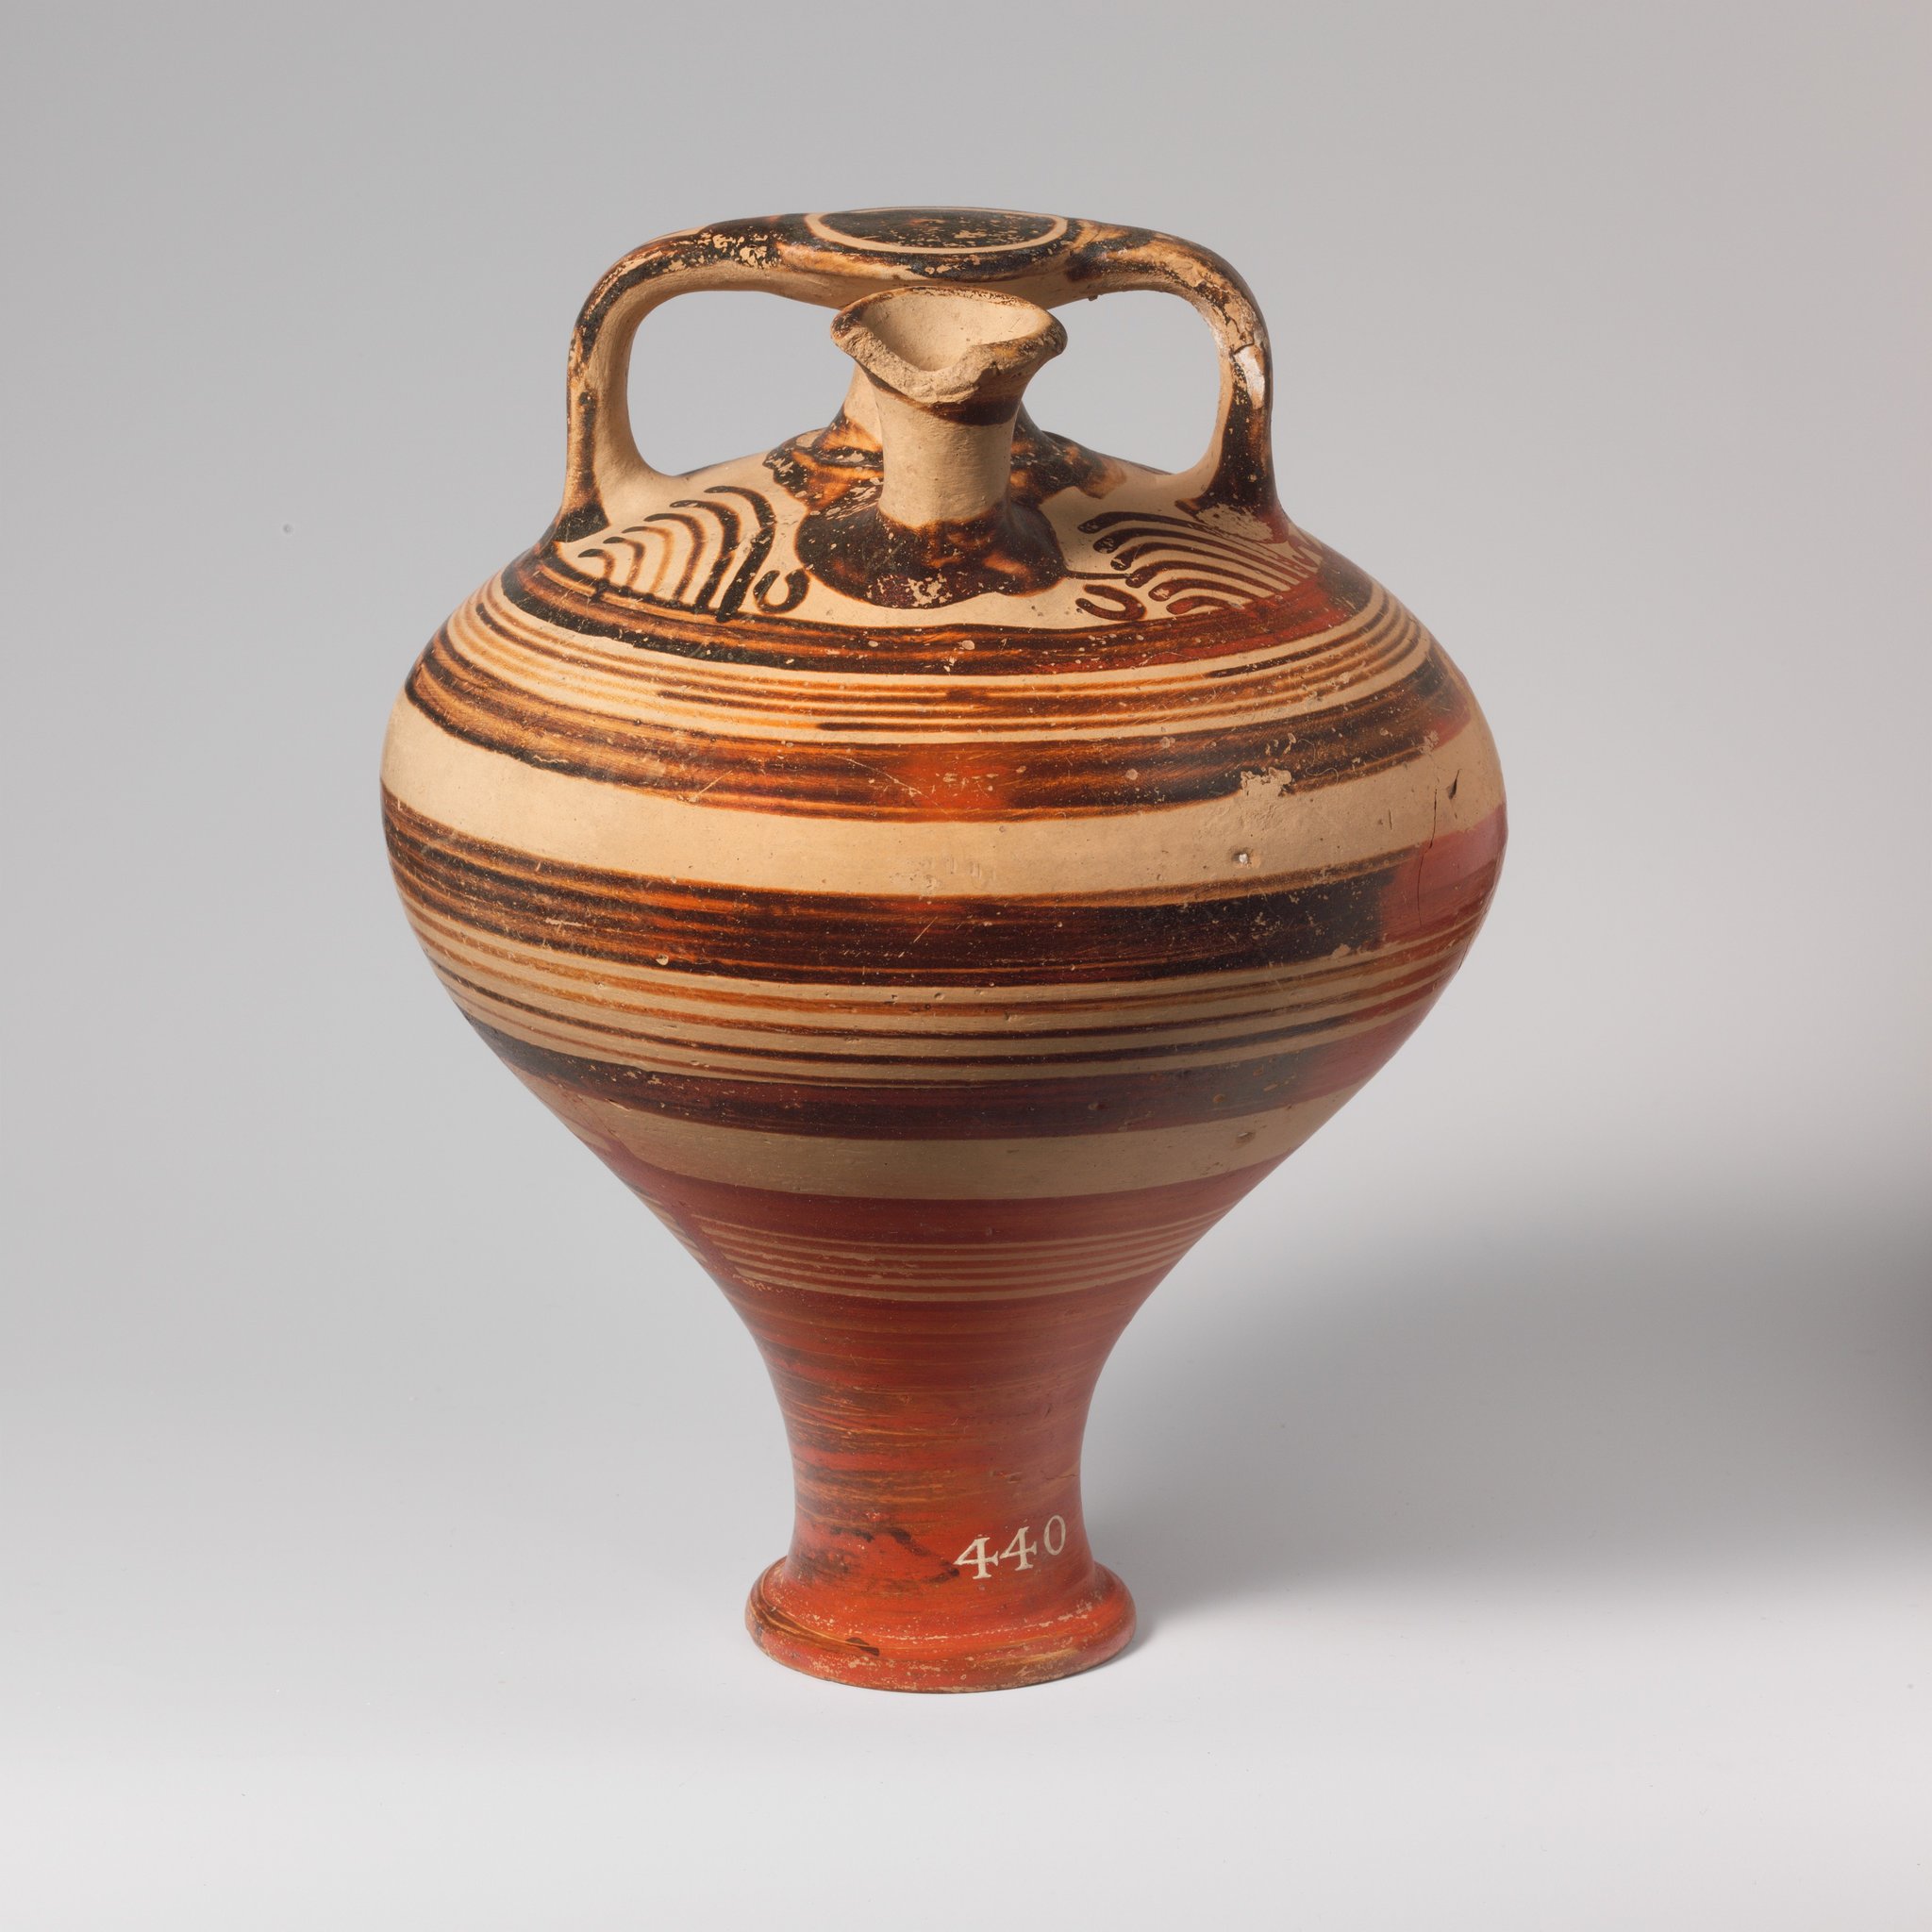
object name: false necked jar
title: Terracotta stirrup jar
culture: mycenaean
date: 1300-1190 BCE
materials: terracotta